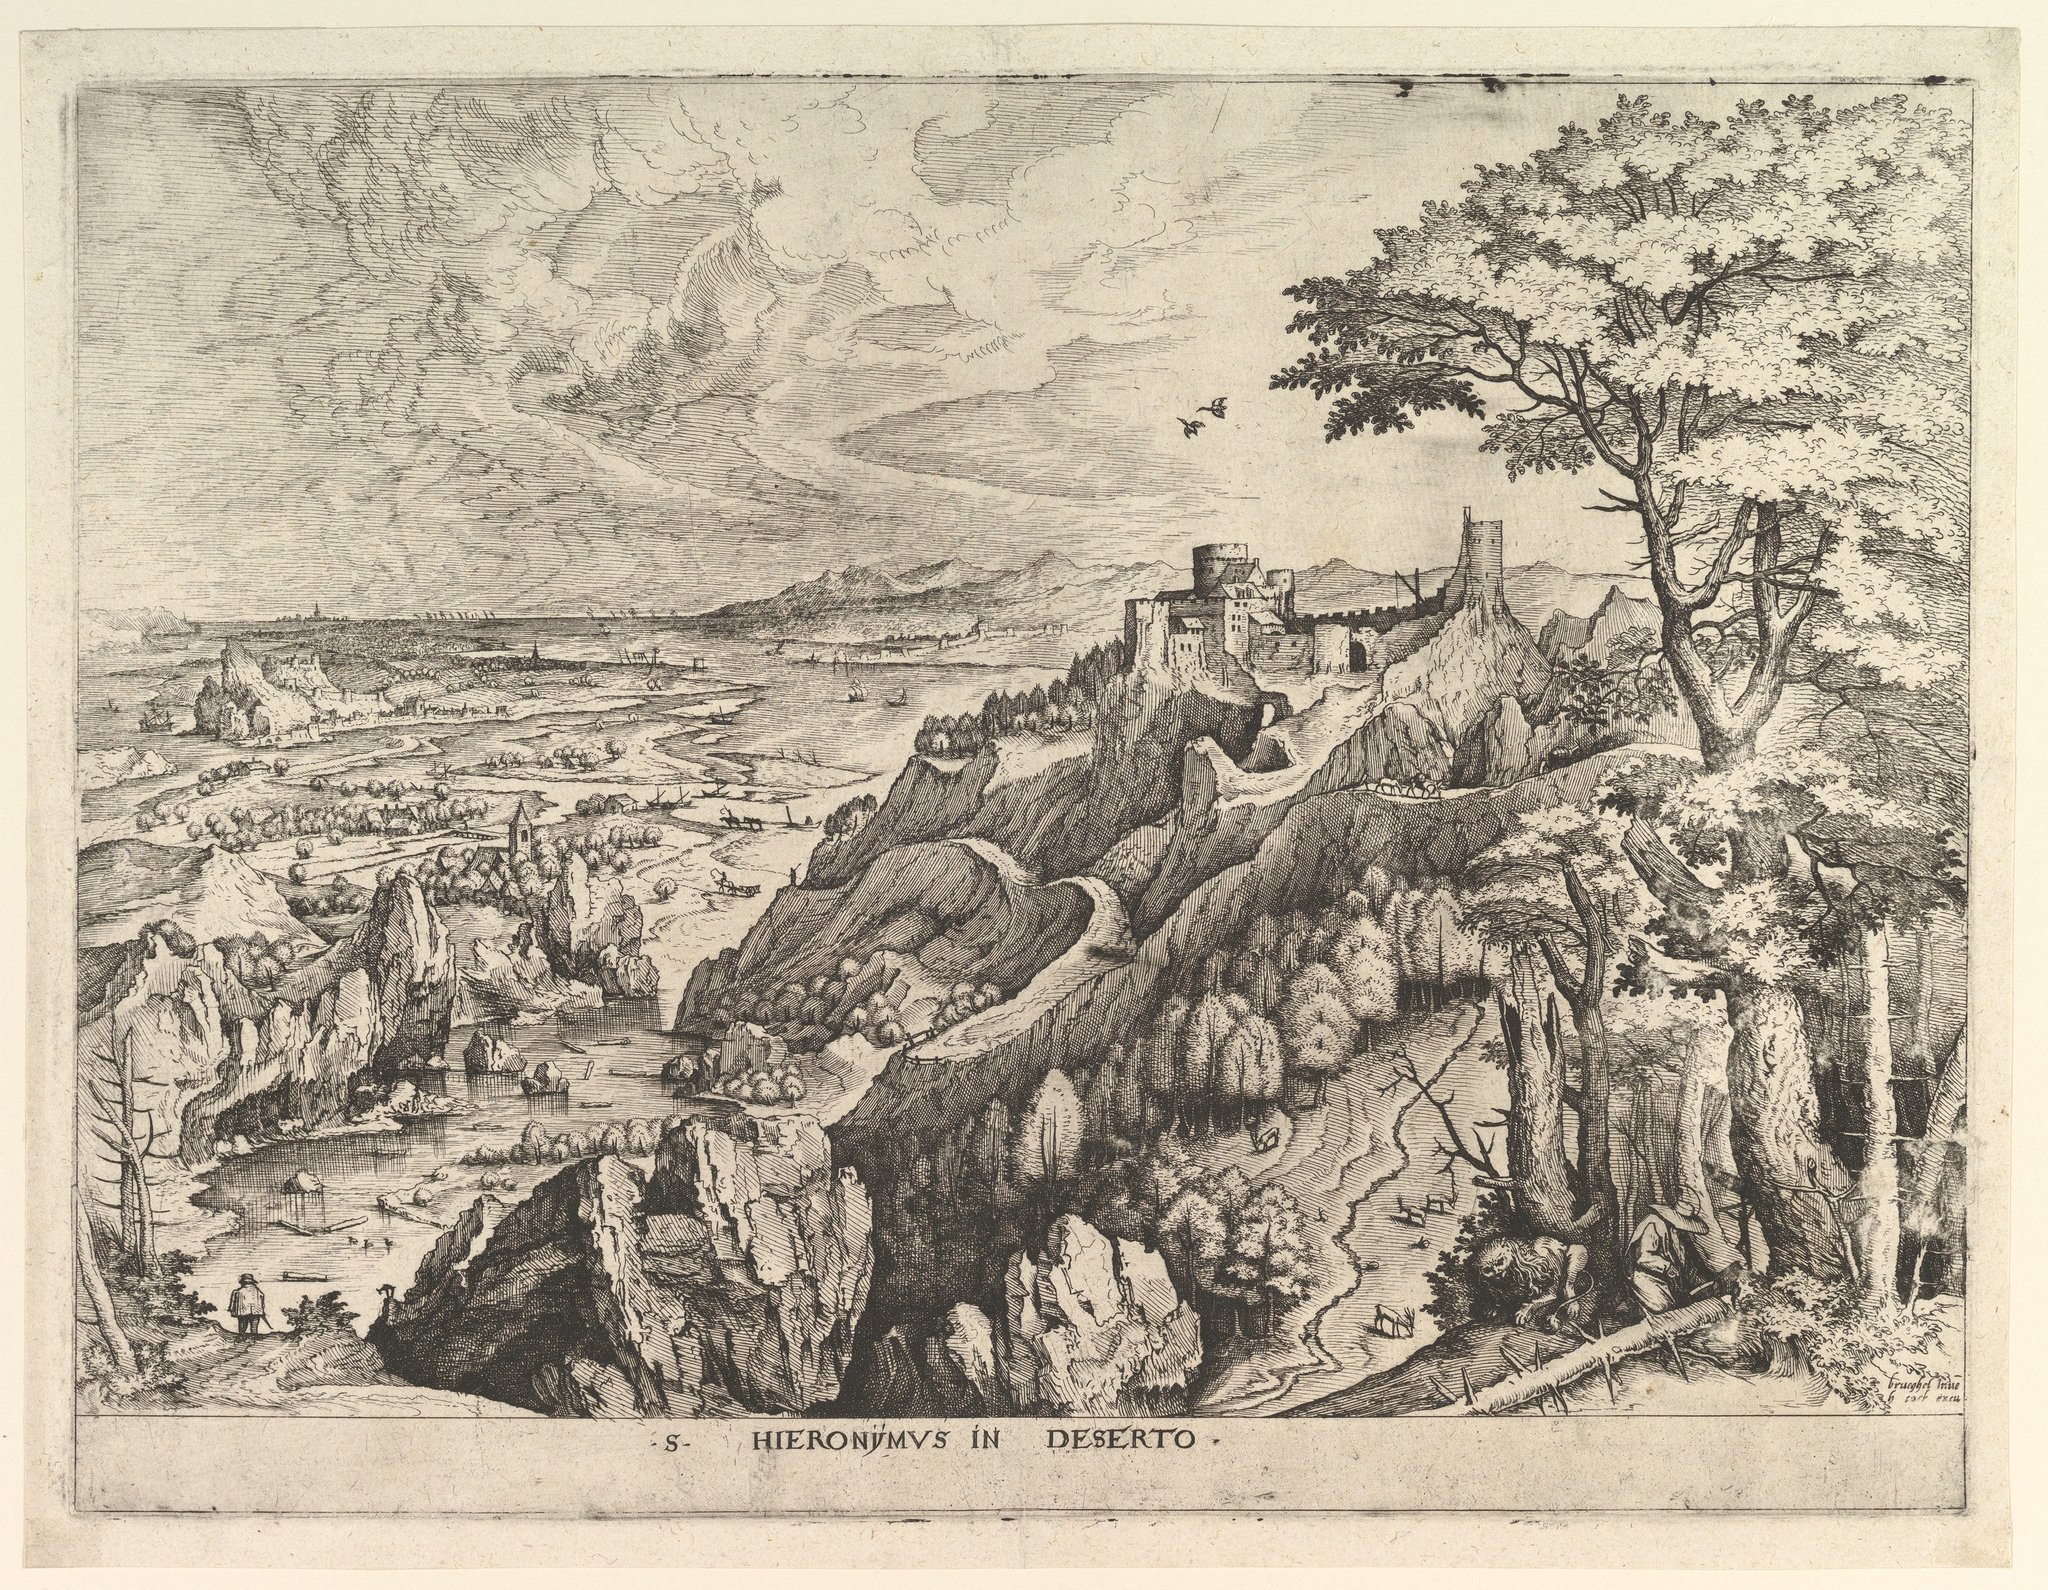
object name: print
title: St. Jerome in the Wilderness (S. Hieronymus in Deserto), from "The Large Landscapes"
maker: johannes van doetecum i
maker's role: artist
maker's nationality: netherlandish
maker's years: 1528-1605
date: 1555-1556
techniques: engraving, etching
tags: landscapes,trees